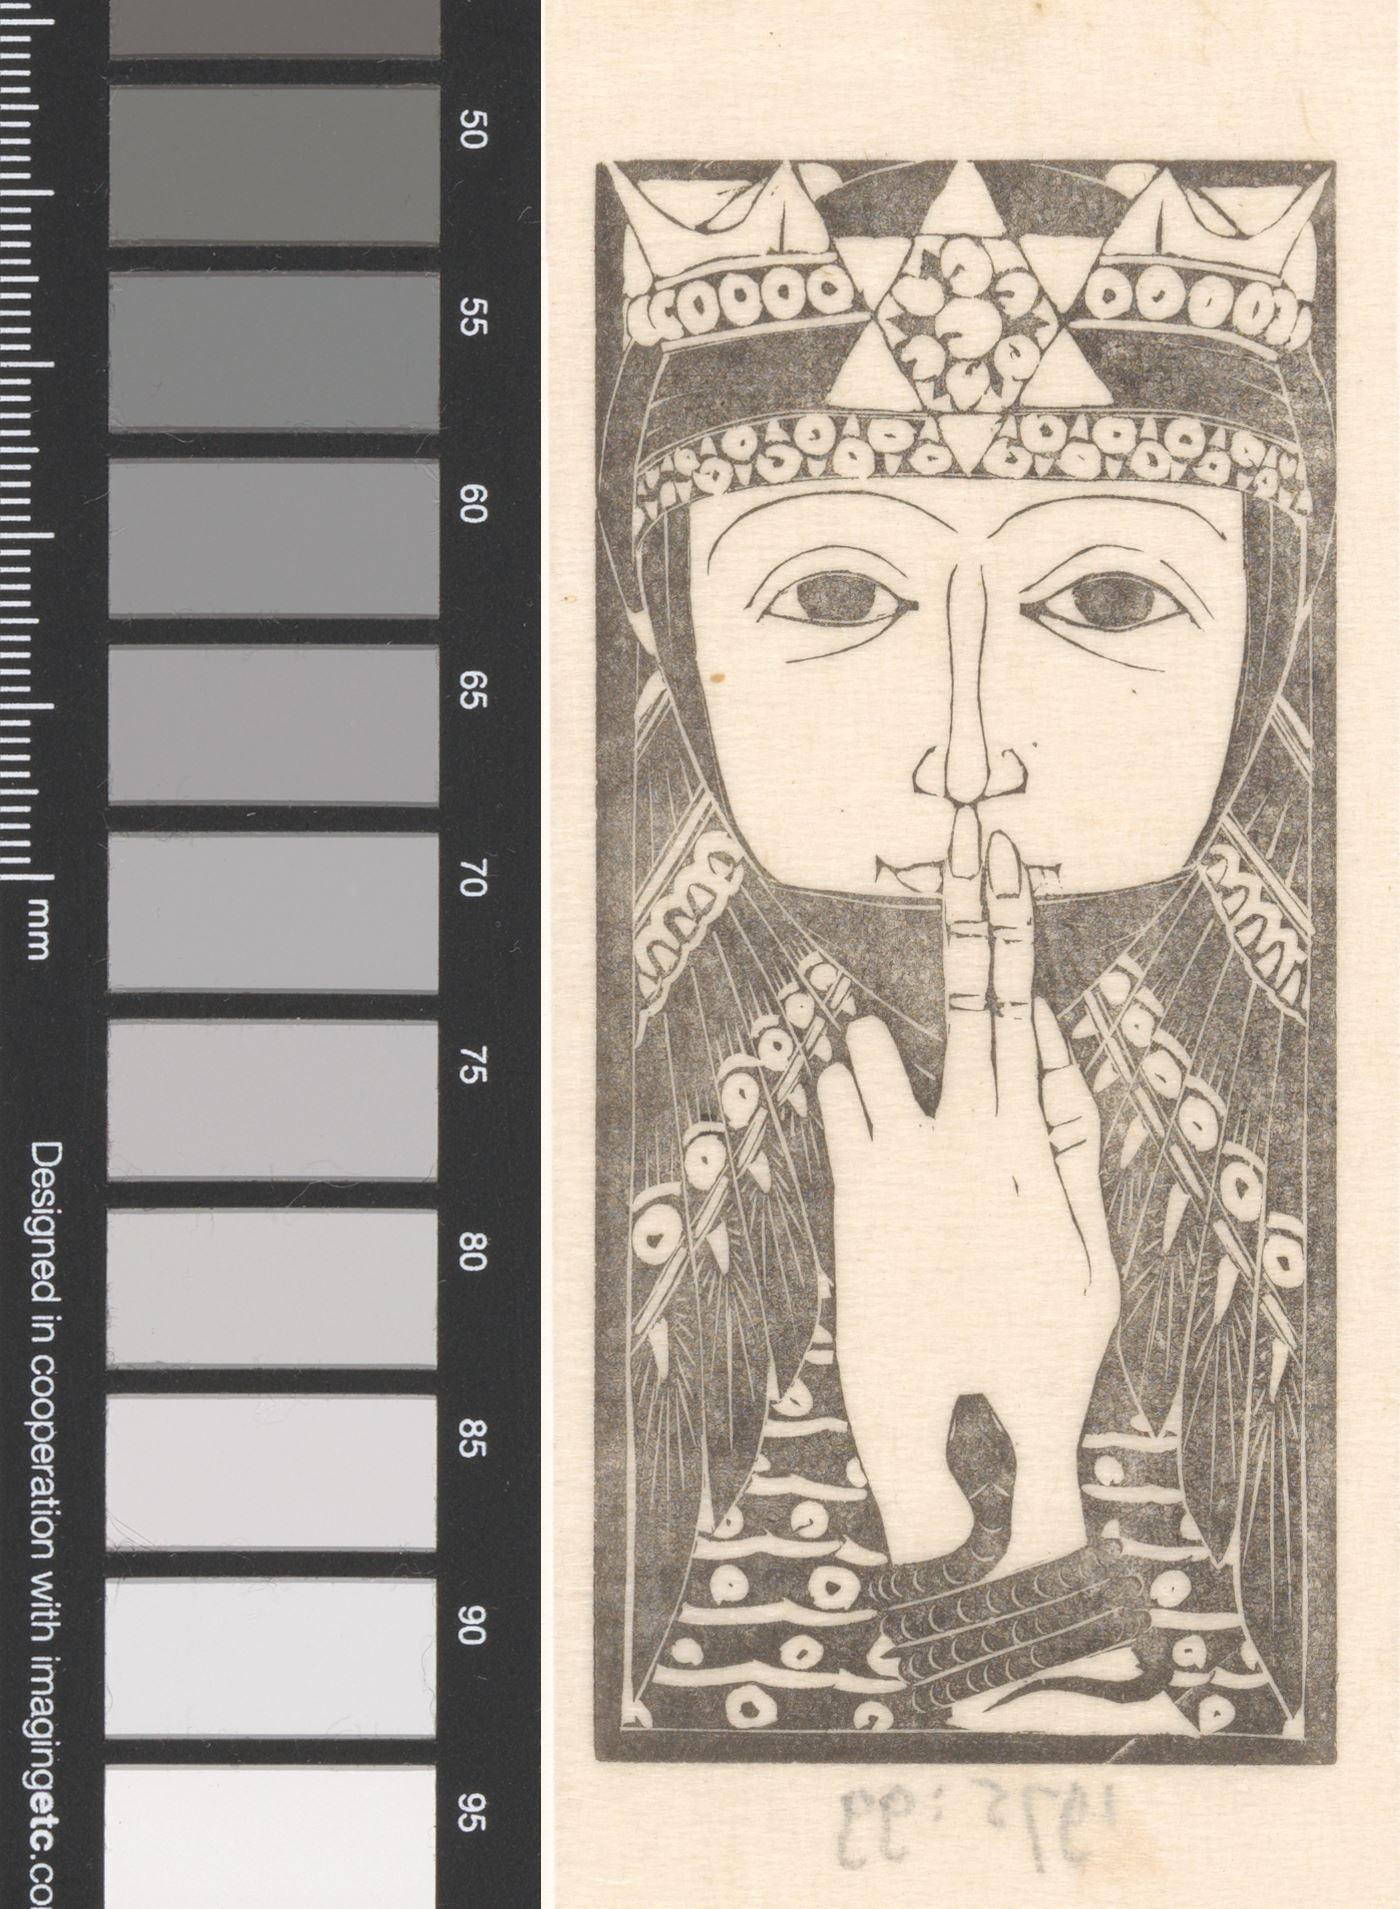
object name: print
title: Vrouw met twee vingers op de lippen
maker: mathieu lauweriks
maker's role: designer, draughtsman, print maker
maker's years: 1864-1932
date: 1895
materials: paper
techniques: woodcut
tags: snakes, putting a finger to the lips, 'silentium'; 'silentio' (ripa)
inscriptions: collector's mark: Lugt 2228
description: Prent mogelijk gebruikt als illustratie van het gedicht 'Bedriegt u zelven niet' en het opstel 'Esotherisch' in: Licht en waarheid. Orgaan van de vereeniging 'Wie Denkt Overwint'. Amsterdam: Wie Denkt Overwint, 29 juni 1895.